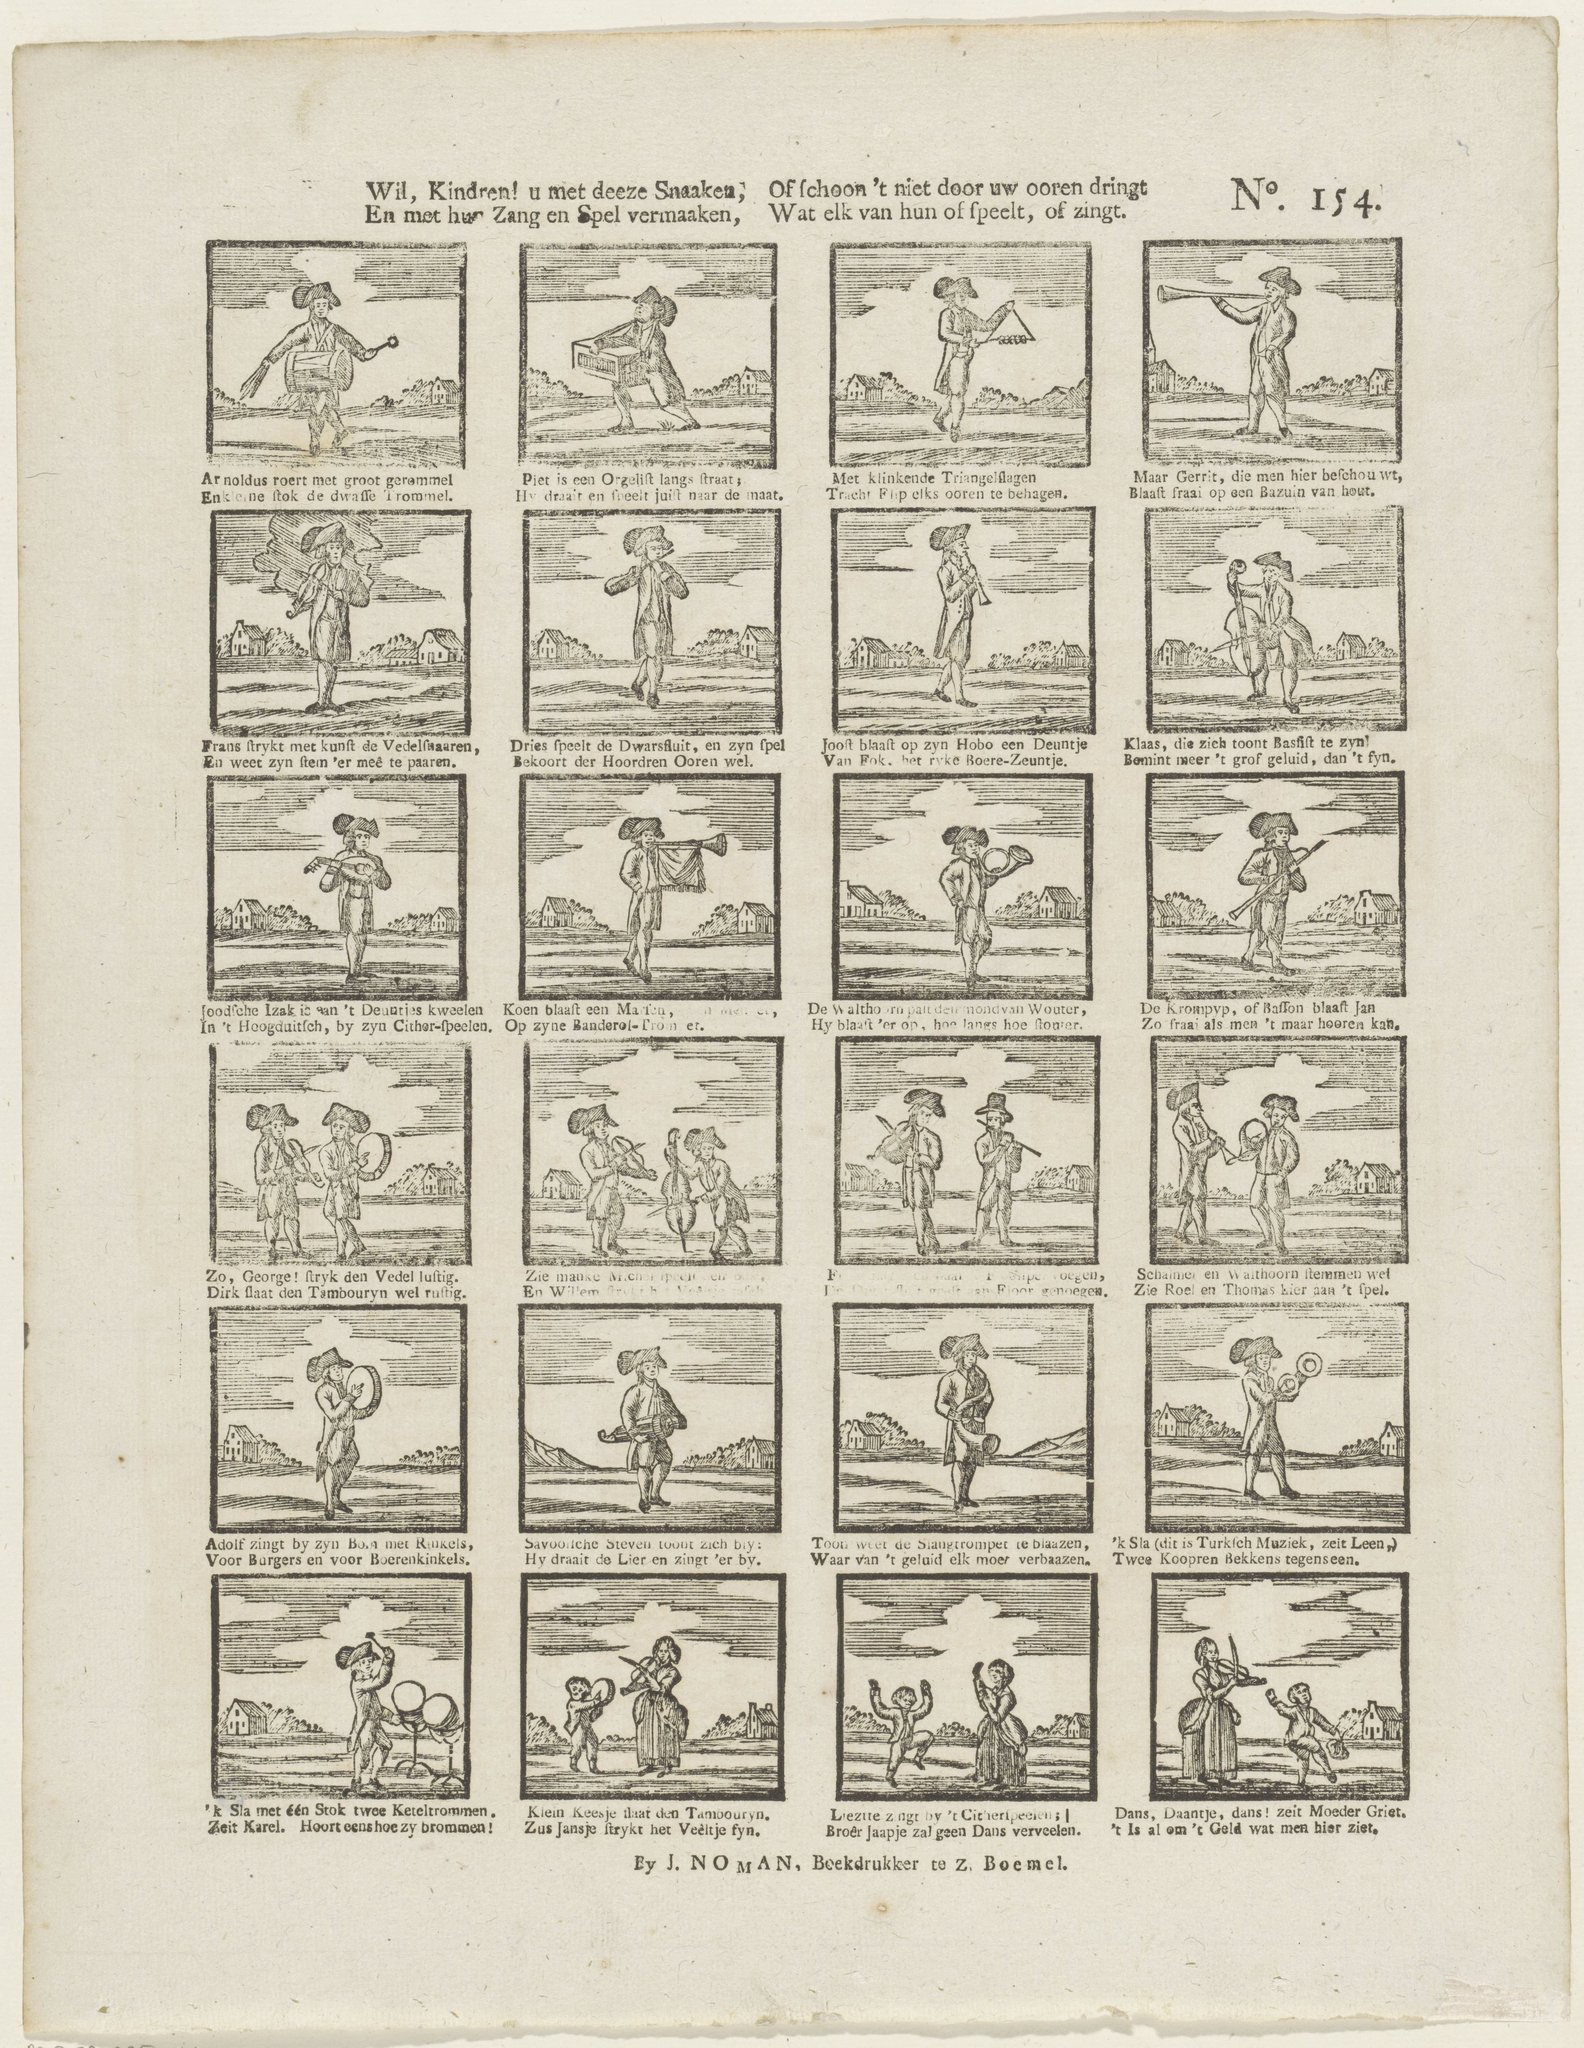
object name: popular print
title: Wil, kindren! u met deeze snaaken, / En met hun zang en spel vermaaken, / of schoon 't niet door uw ooren dringt / Wat elk van hun of speelt, of zingt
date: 1806-1830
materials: paper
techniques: letterpress printing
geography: zaltbommel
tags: musician at work, musician, making music; musician with instrument, musician - cc - out of doors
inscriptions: collector's mark: Lugt 2760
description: Blad met 24 voorstellingen van muzikanten met verschillende muziekinstrumenten. Onder elke afbeelding een tweeregelig vers. Genummerd rechtsboven: No 154.